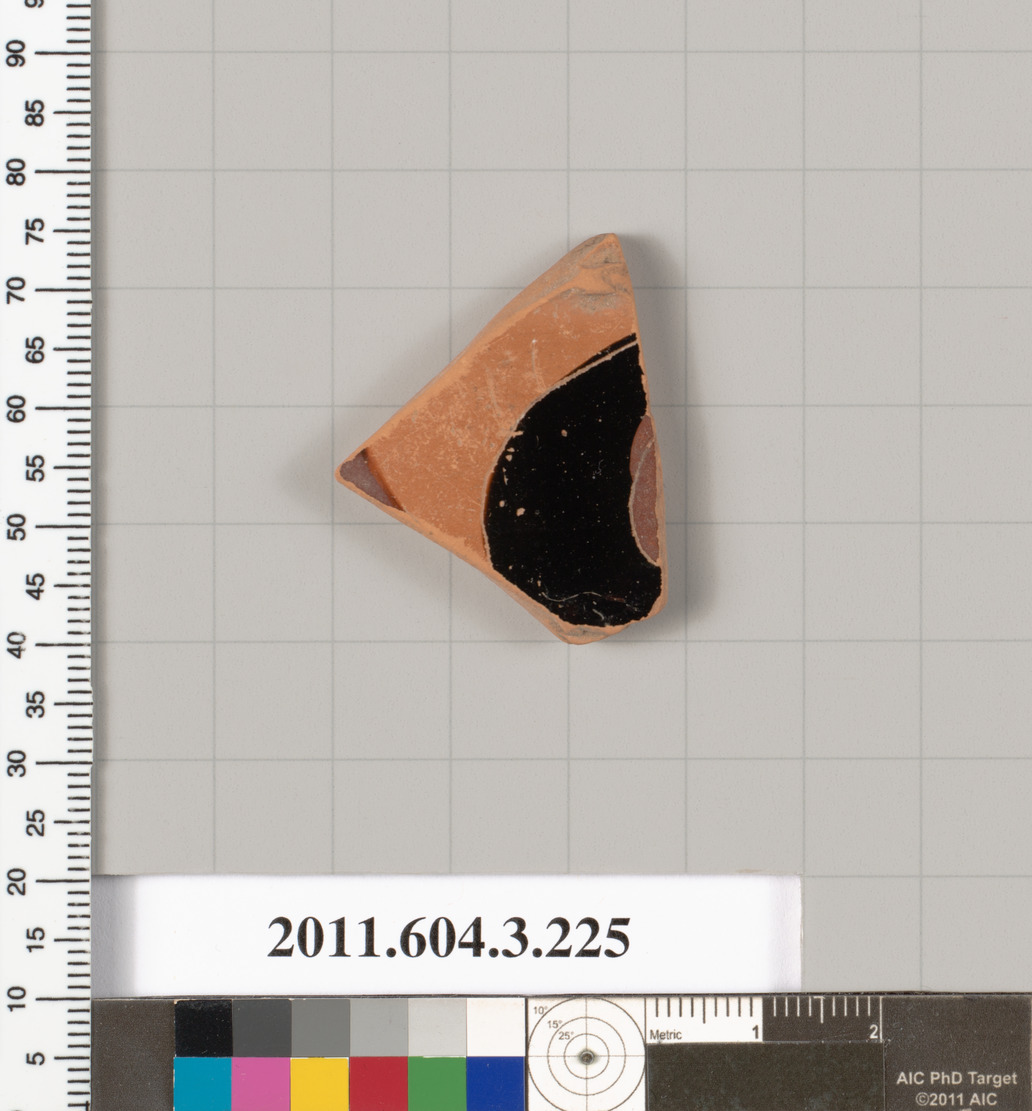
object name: neck amphora fragment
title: Terracotta fragment of a neck-amphora of Nicosthenic shape (jar)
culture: greek, attic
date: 525-501 BCE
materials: terracotta